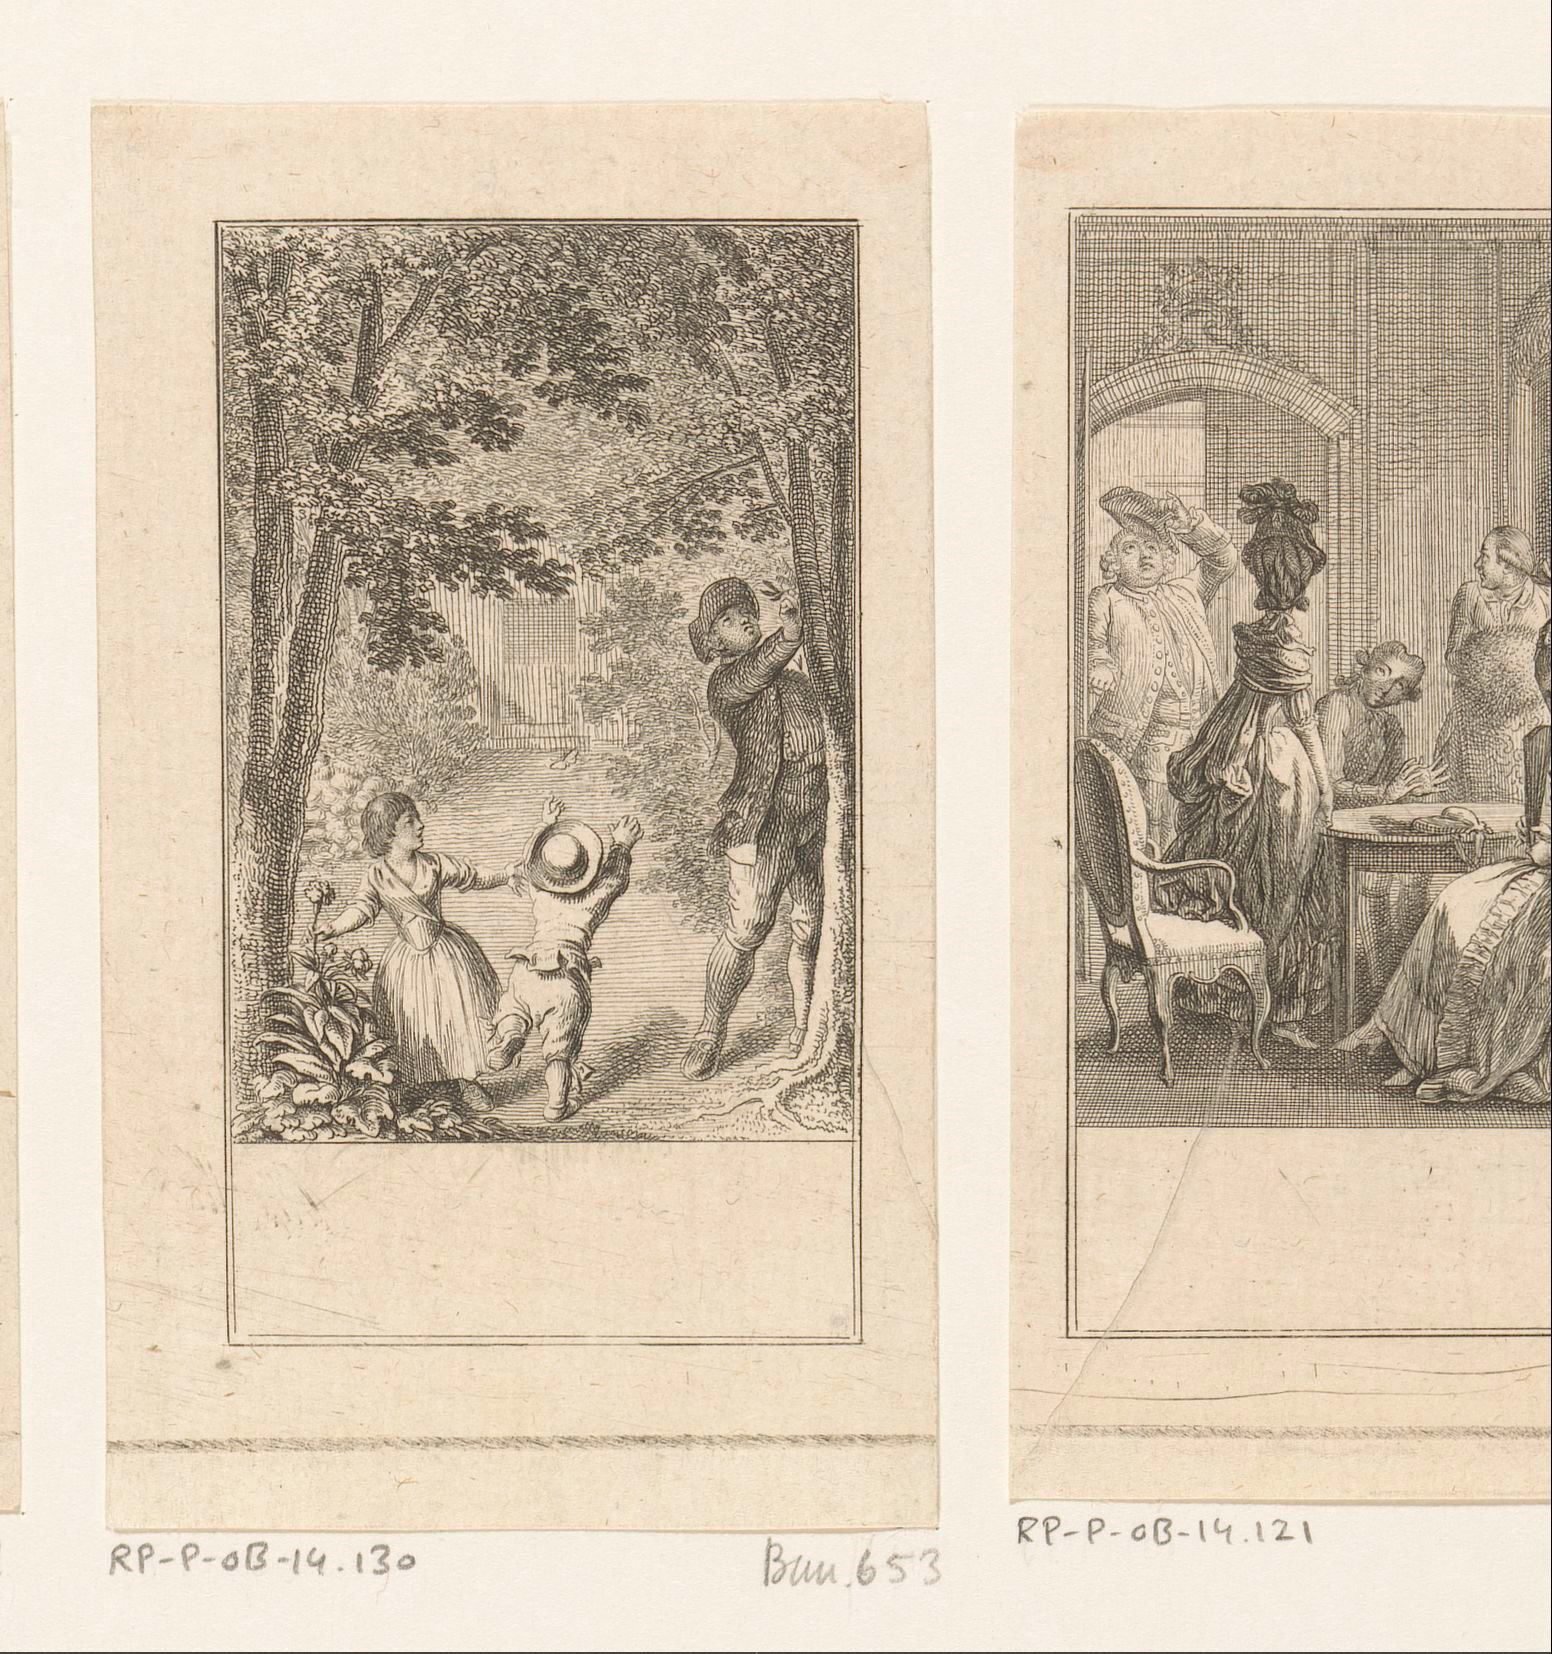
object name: print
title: Man met kinderen in zijn tuin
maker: daniel nikolaus chodowiecki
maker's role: draughtsman, print maker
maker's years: 1726-1801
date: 1779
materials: paper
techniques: etching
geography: berlin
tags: garden, father and child(ren), man and child(ren) (family group)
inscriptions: collector's mark: Lugt 2228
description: Vijfde prent afkomstig uit een serie van twaalf verschillende prenten. Deze serie is een herhaling van dezelfde serie met onderschriften in het Duits (zie: RP-P-OB-14.106). De scènes zijn op een plaat geëtst. Deze staat niet beschreven in Engelmann: met uitwerking van de lucht en schaduwpartijen maar voor toevoeging van nummers en onderschriften. Een latere staat van deze serie is ook gebruikt in: Almanac genealogique de Lauenbourg pour l'année 1780.